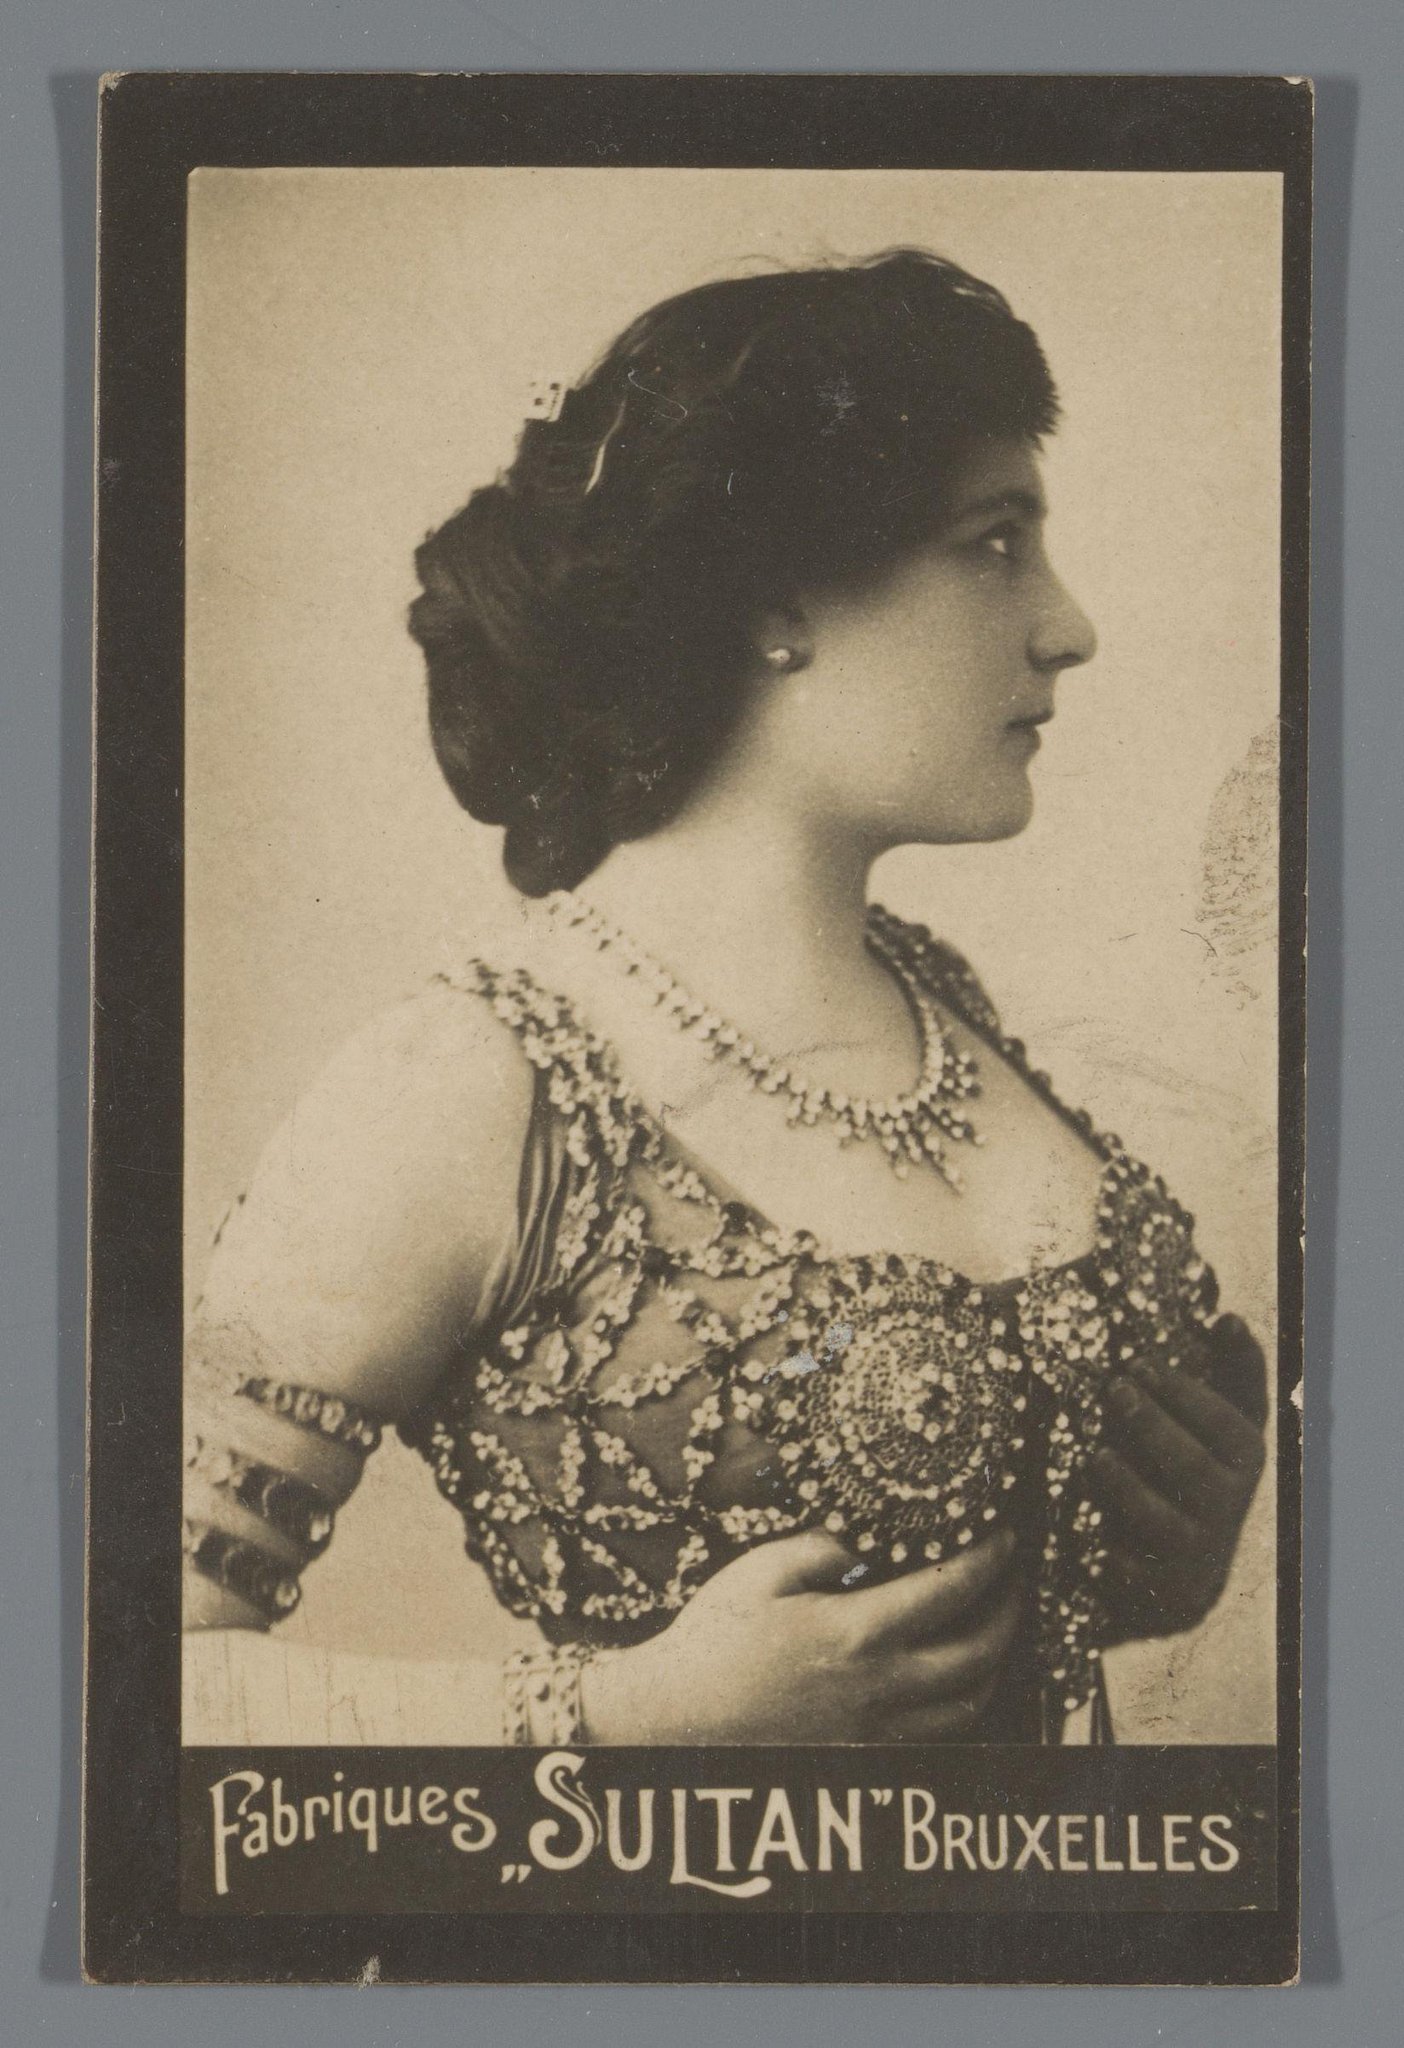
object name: photograph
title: Portret van een onbekende vrouw met ketting, reclame voor Fabriques "Sultan" Bruxelles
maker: Anonymous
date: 1895-1915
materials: photographic support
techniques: gelatin silver print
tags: historical persons - bb - woman, necklace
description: Dergelijke foto's stonden bekend als 'zwartjes'. Men verkreeg ze bij aanschaf van bepaalde merken thee, cacao, sigaretten, beschuit, etc. om te verzamelen. Er waren speciaal voor de 'zwartjes' verzamelalbums in omloop.